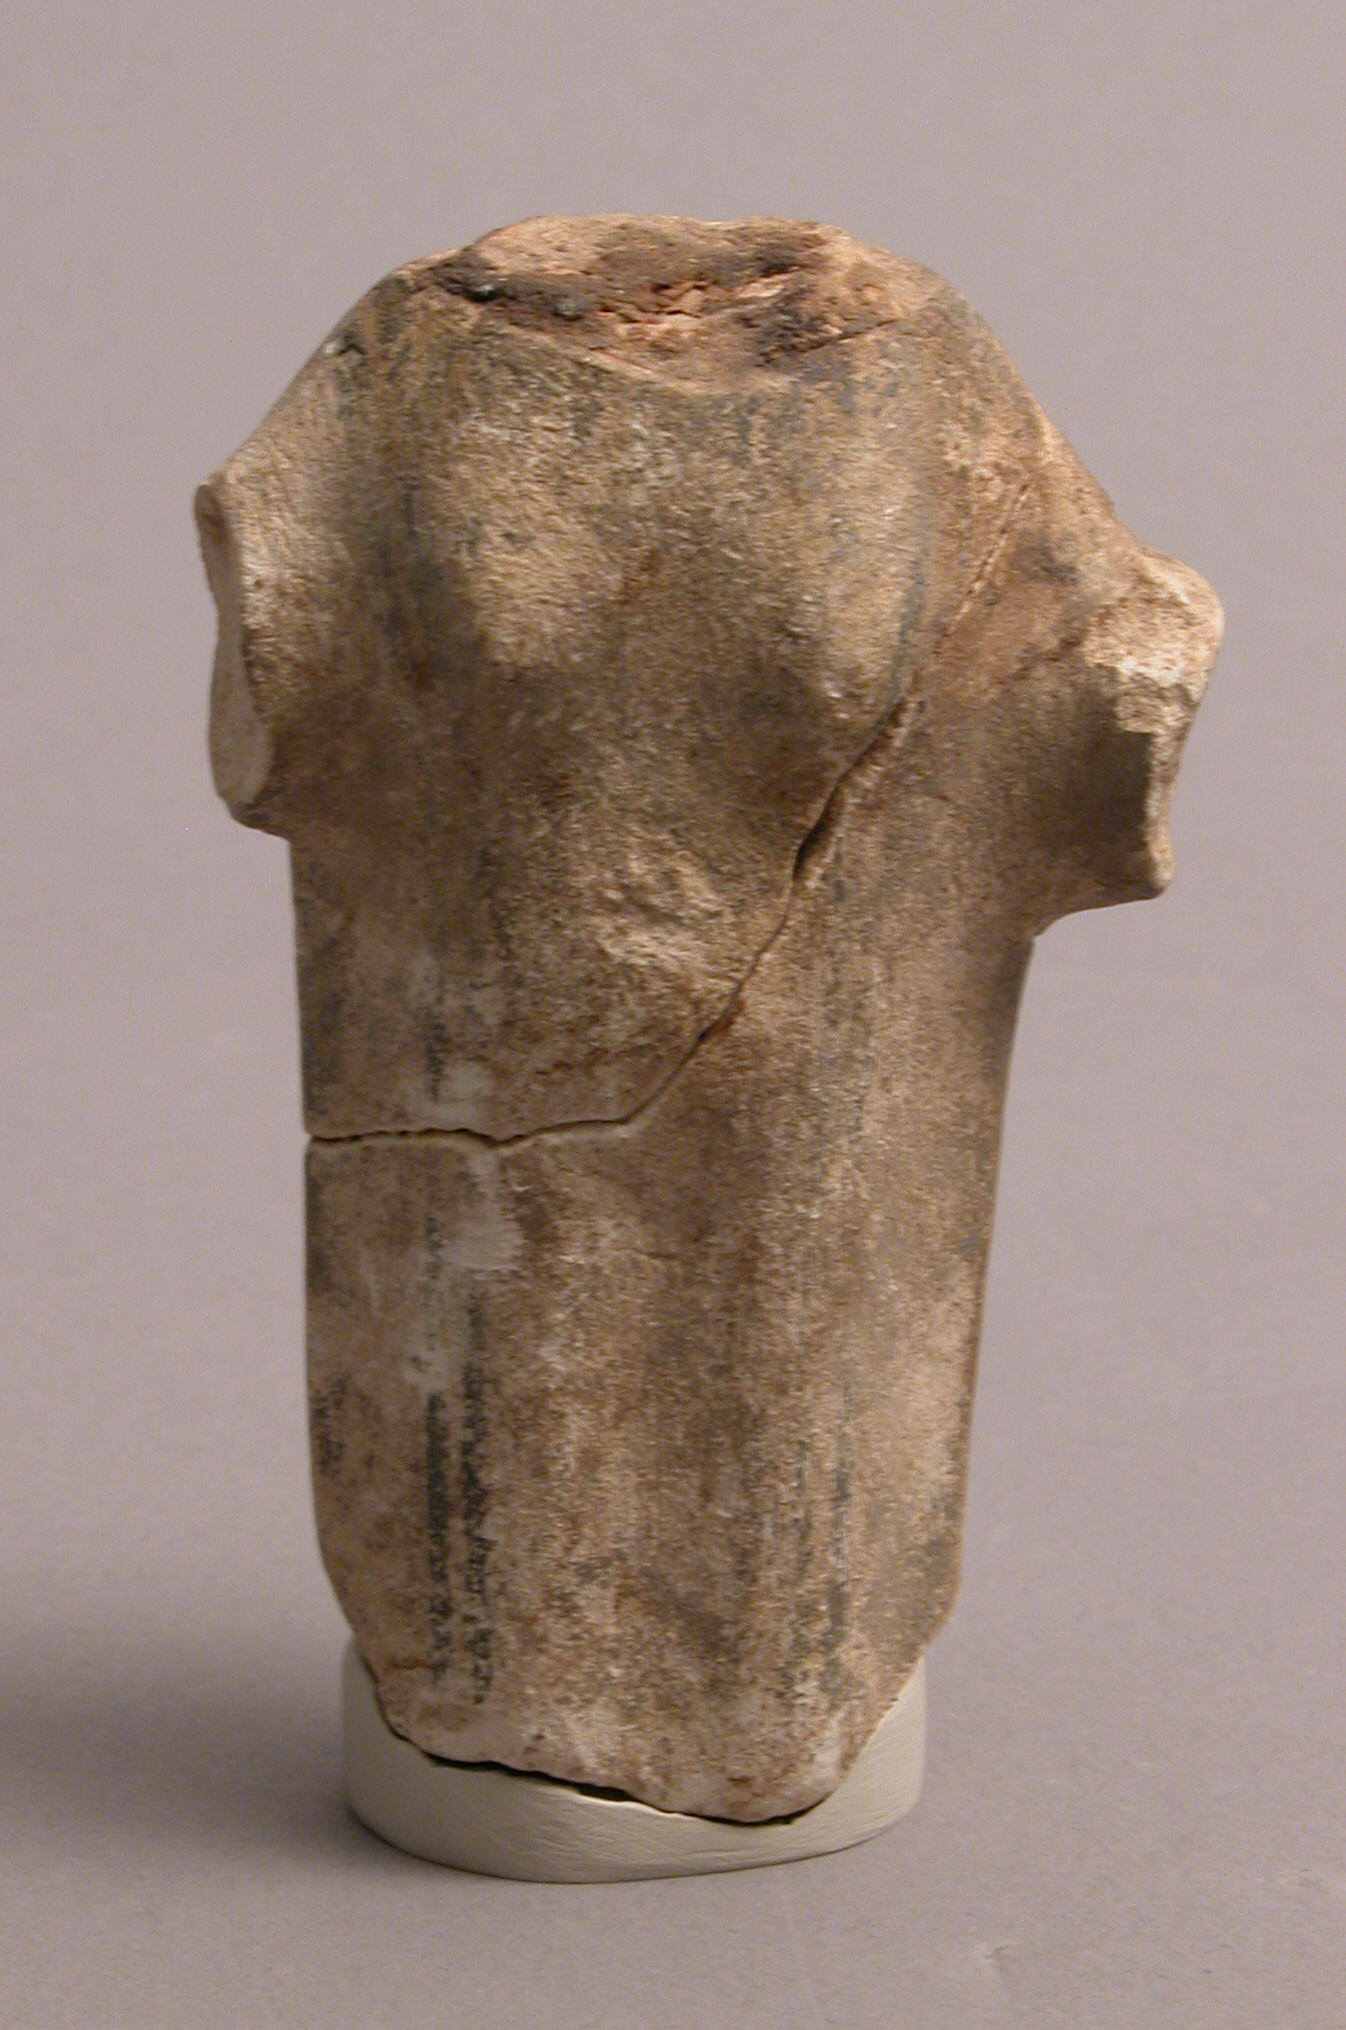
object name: statuette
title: Fragment of a Figure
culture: coptic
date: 301-700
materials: earthenware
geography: egypt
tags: human figures